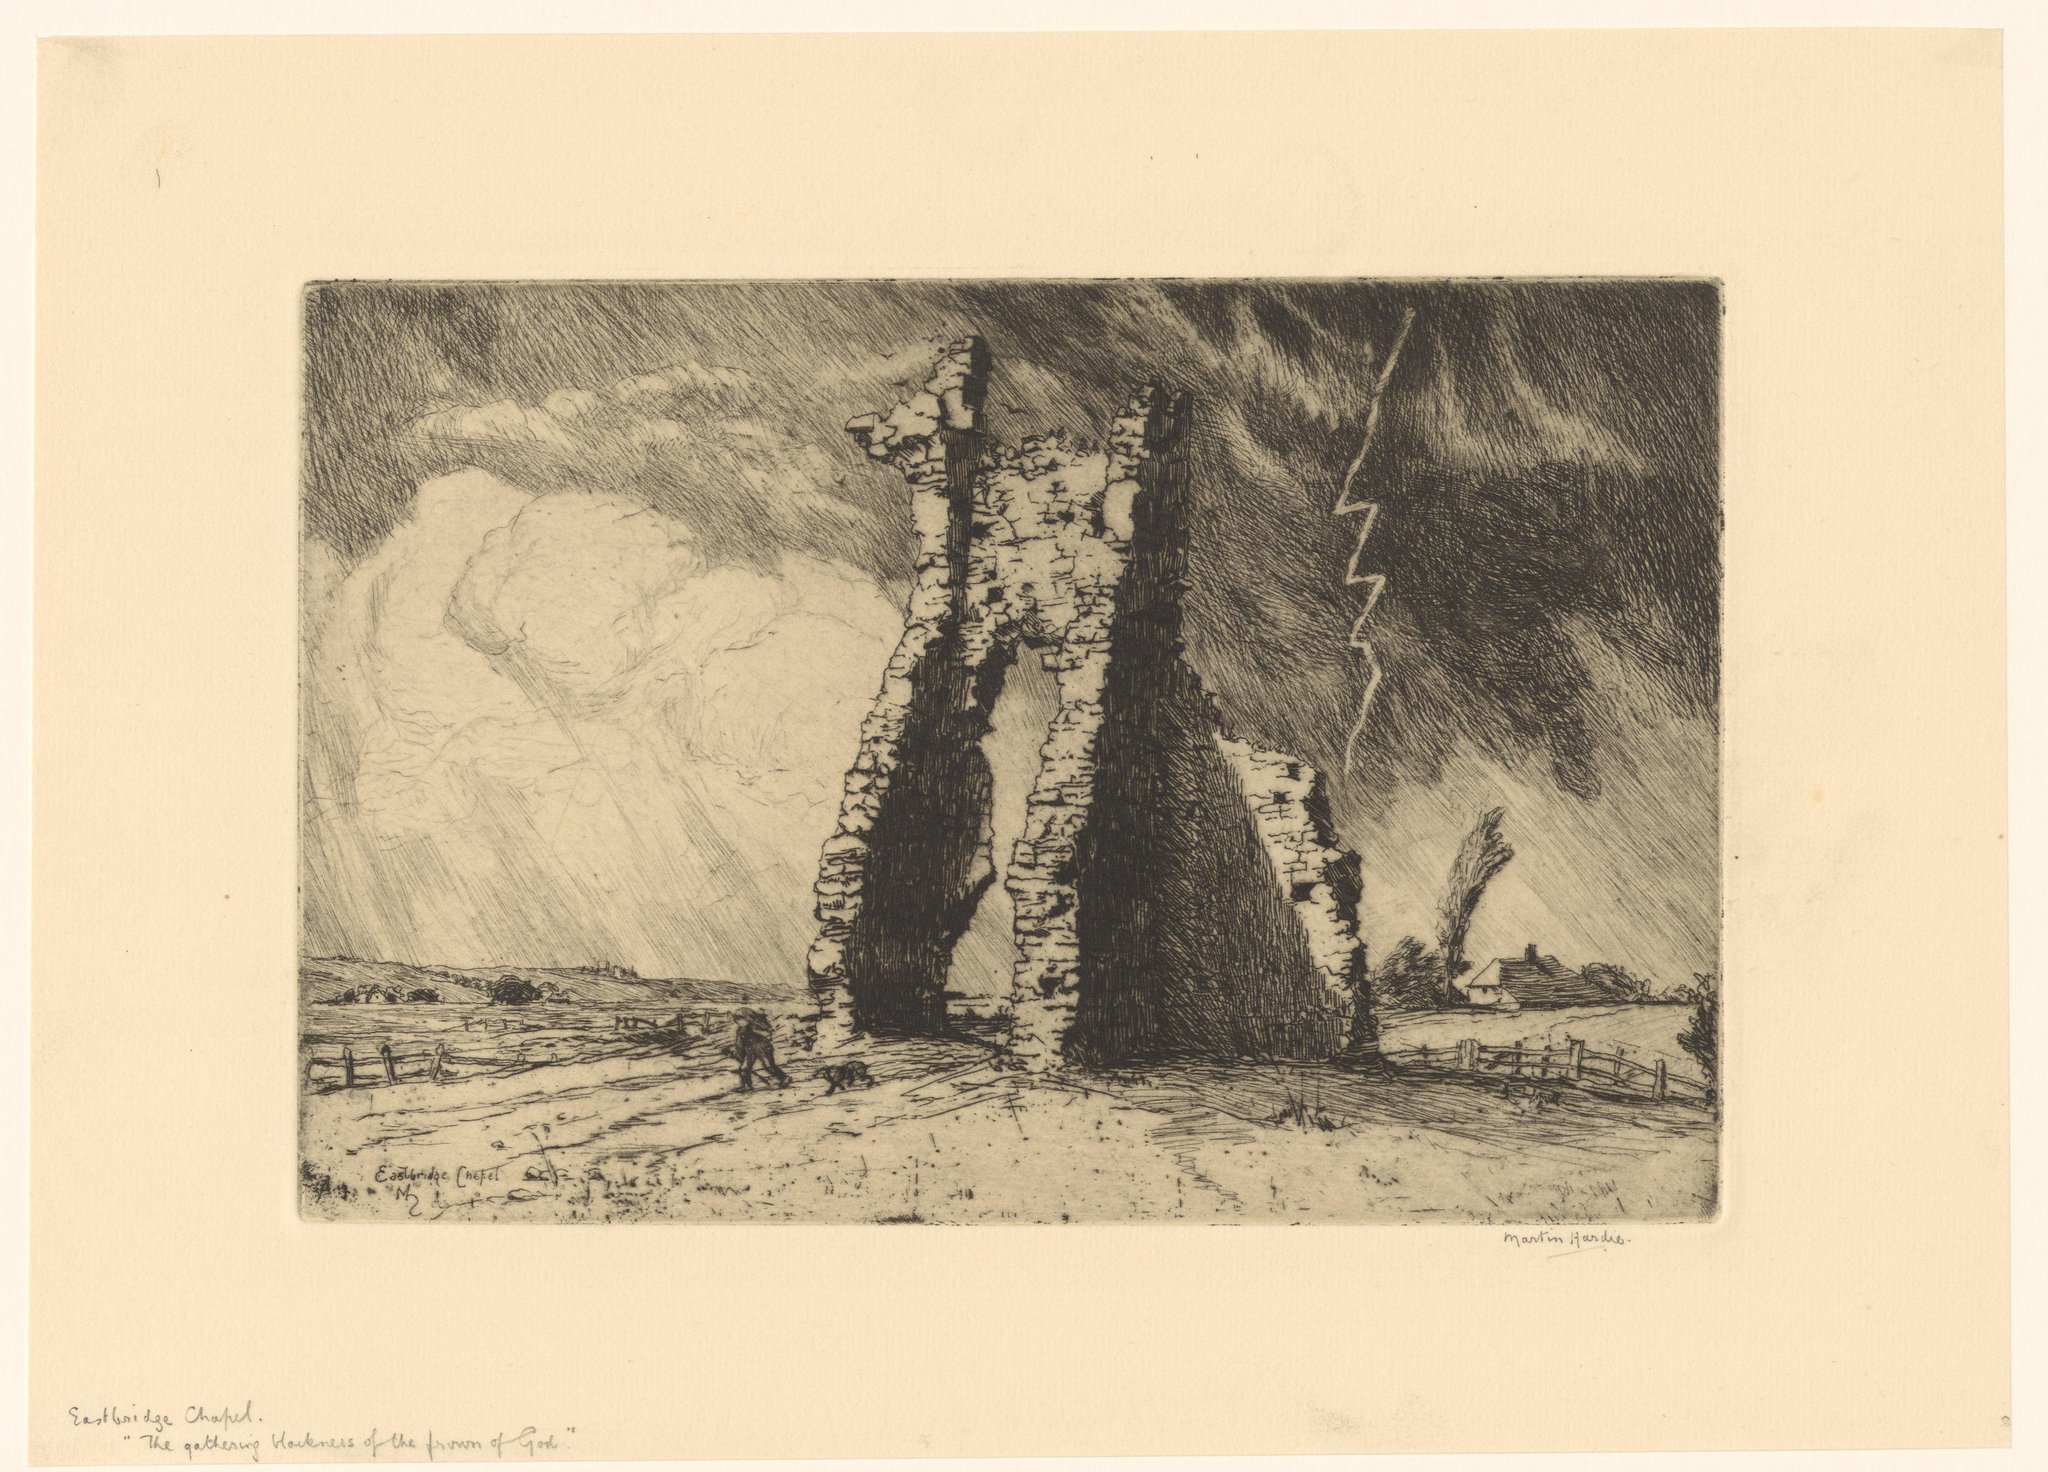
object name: print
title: Eastbridge Chapel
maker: martin hardie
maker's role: print maker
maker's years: 1875-1952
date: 1909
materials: paper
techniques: drypoint, etching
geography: leiston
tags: ruin of a building ~ architecture, thunderstorm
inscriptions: collector's mark: Lugt 2228, annotation: ‘Martin Hardie’, collector's mark: Lugt 2760